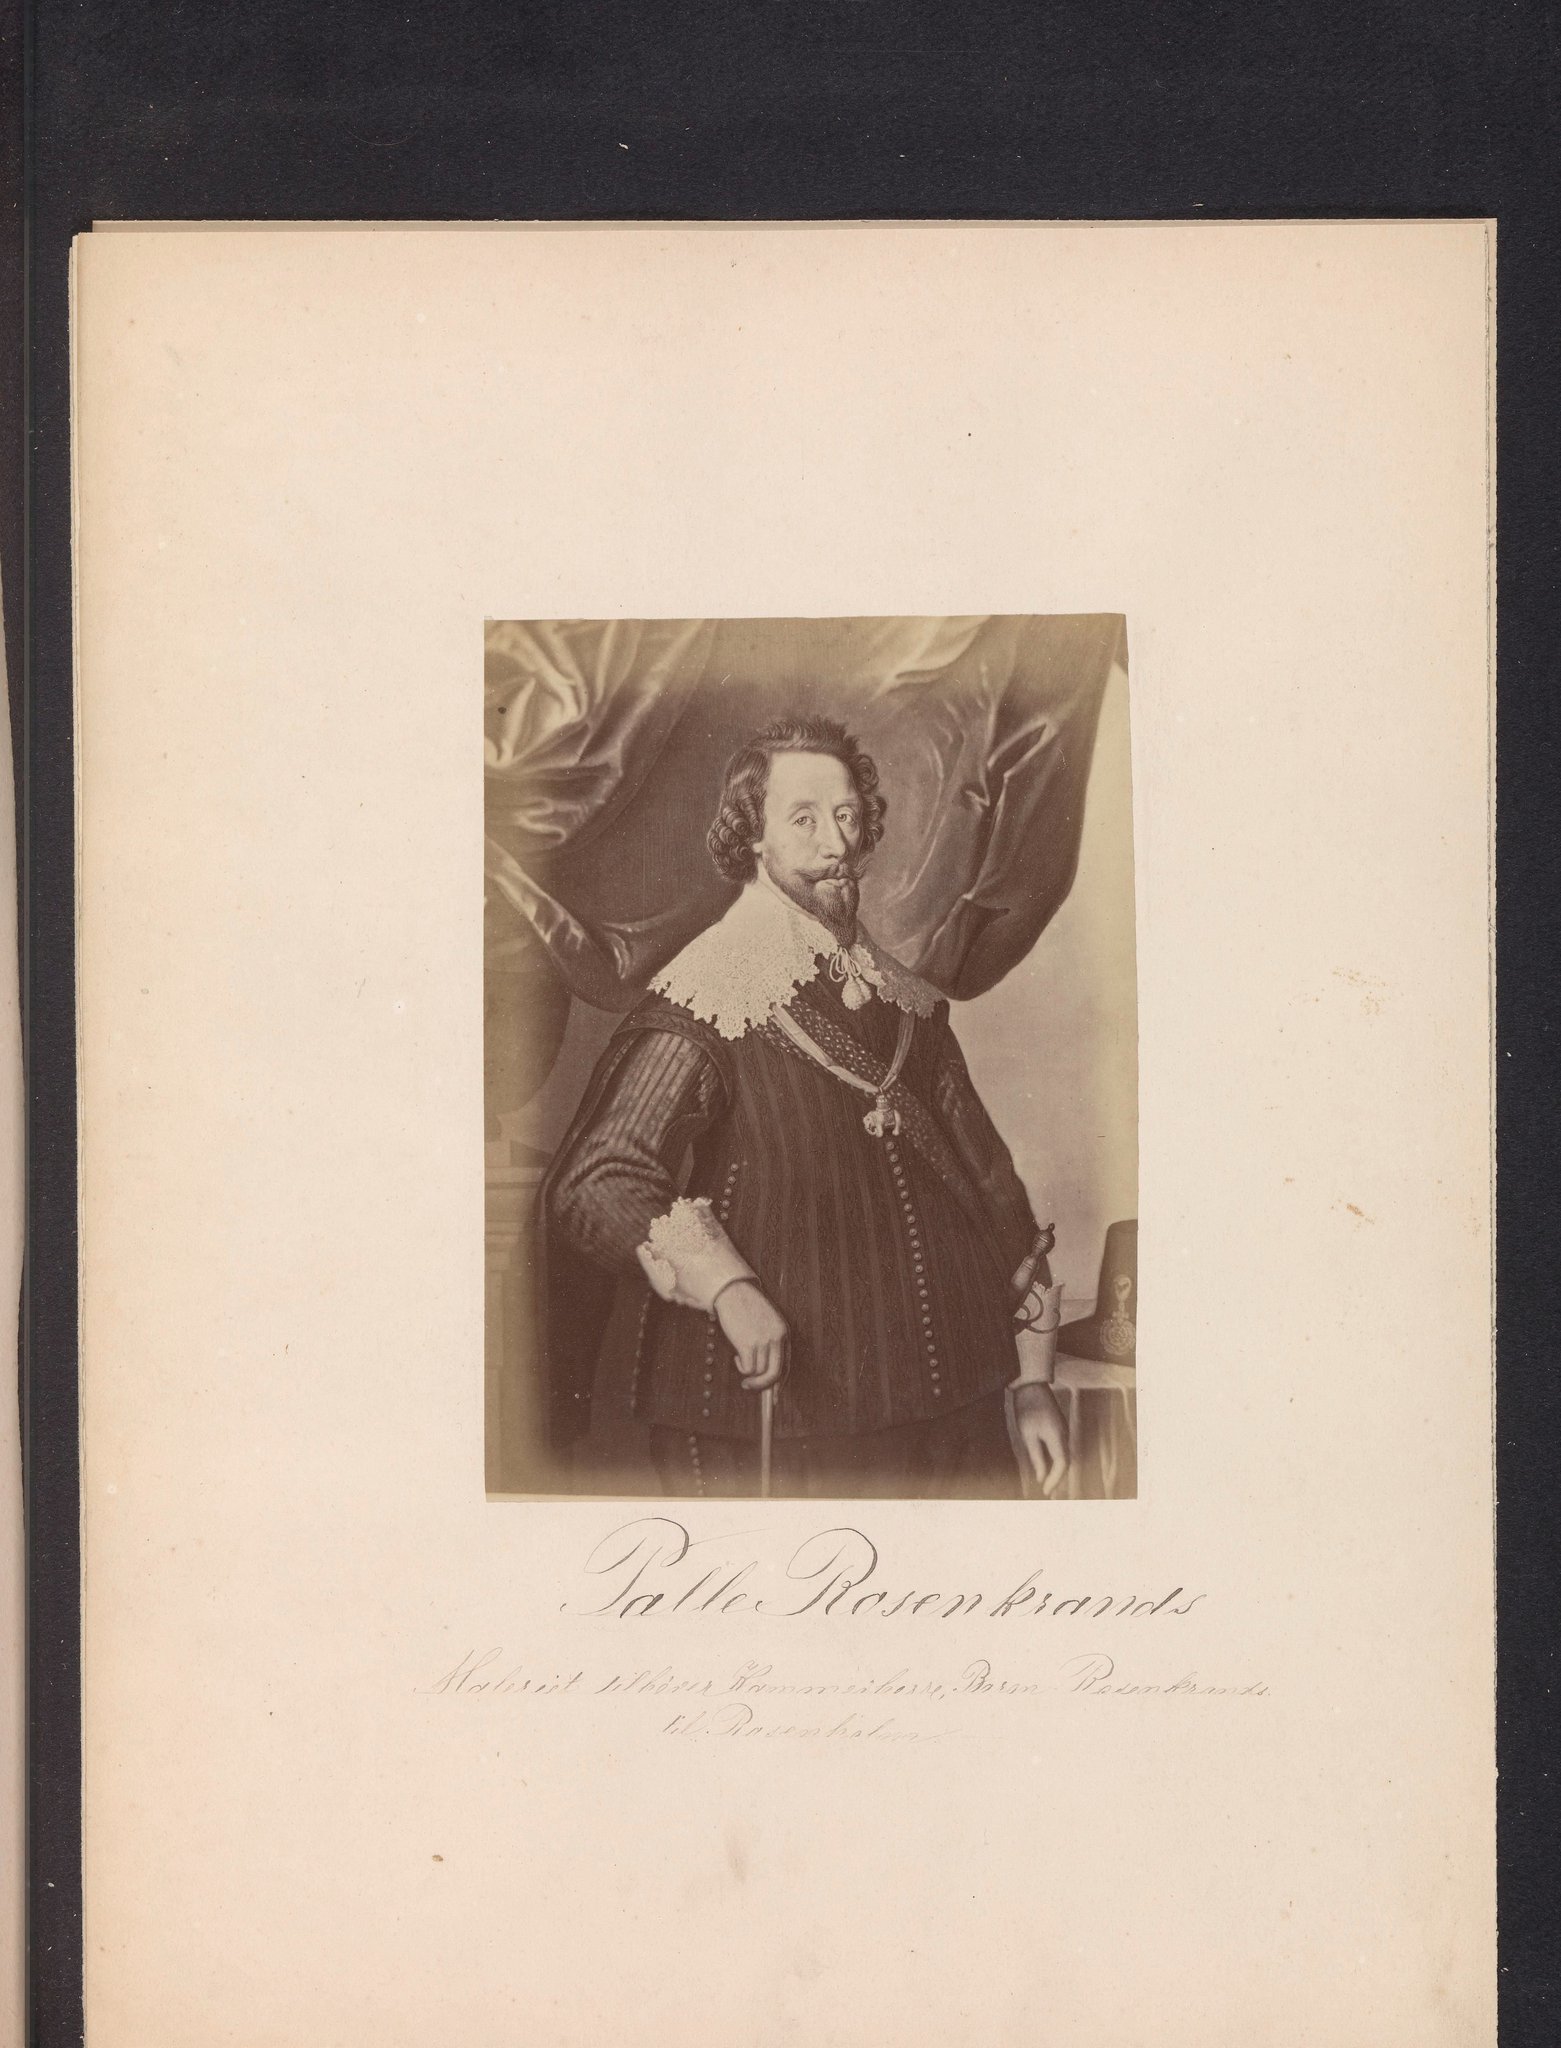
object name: page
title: Fotoreproductie van een schilderij, voorstellende een portret van Palle Rosenkrantz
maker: julius wulff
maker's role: fotograaf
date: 1858-1862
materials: photographic support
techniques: albumen print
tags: writer, poet, author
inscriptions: inscription: ‘Maleriet tillhører Kammerherre, Baron Rosenkrands til Rosenholm.’